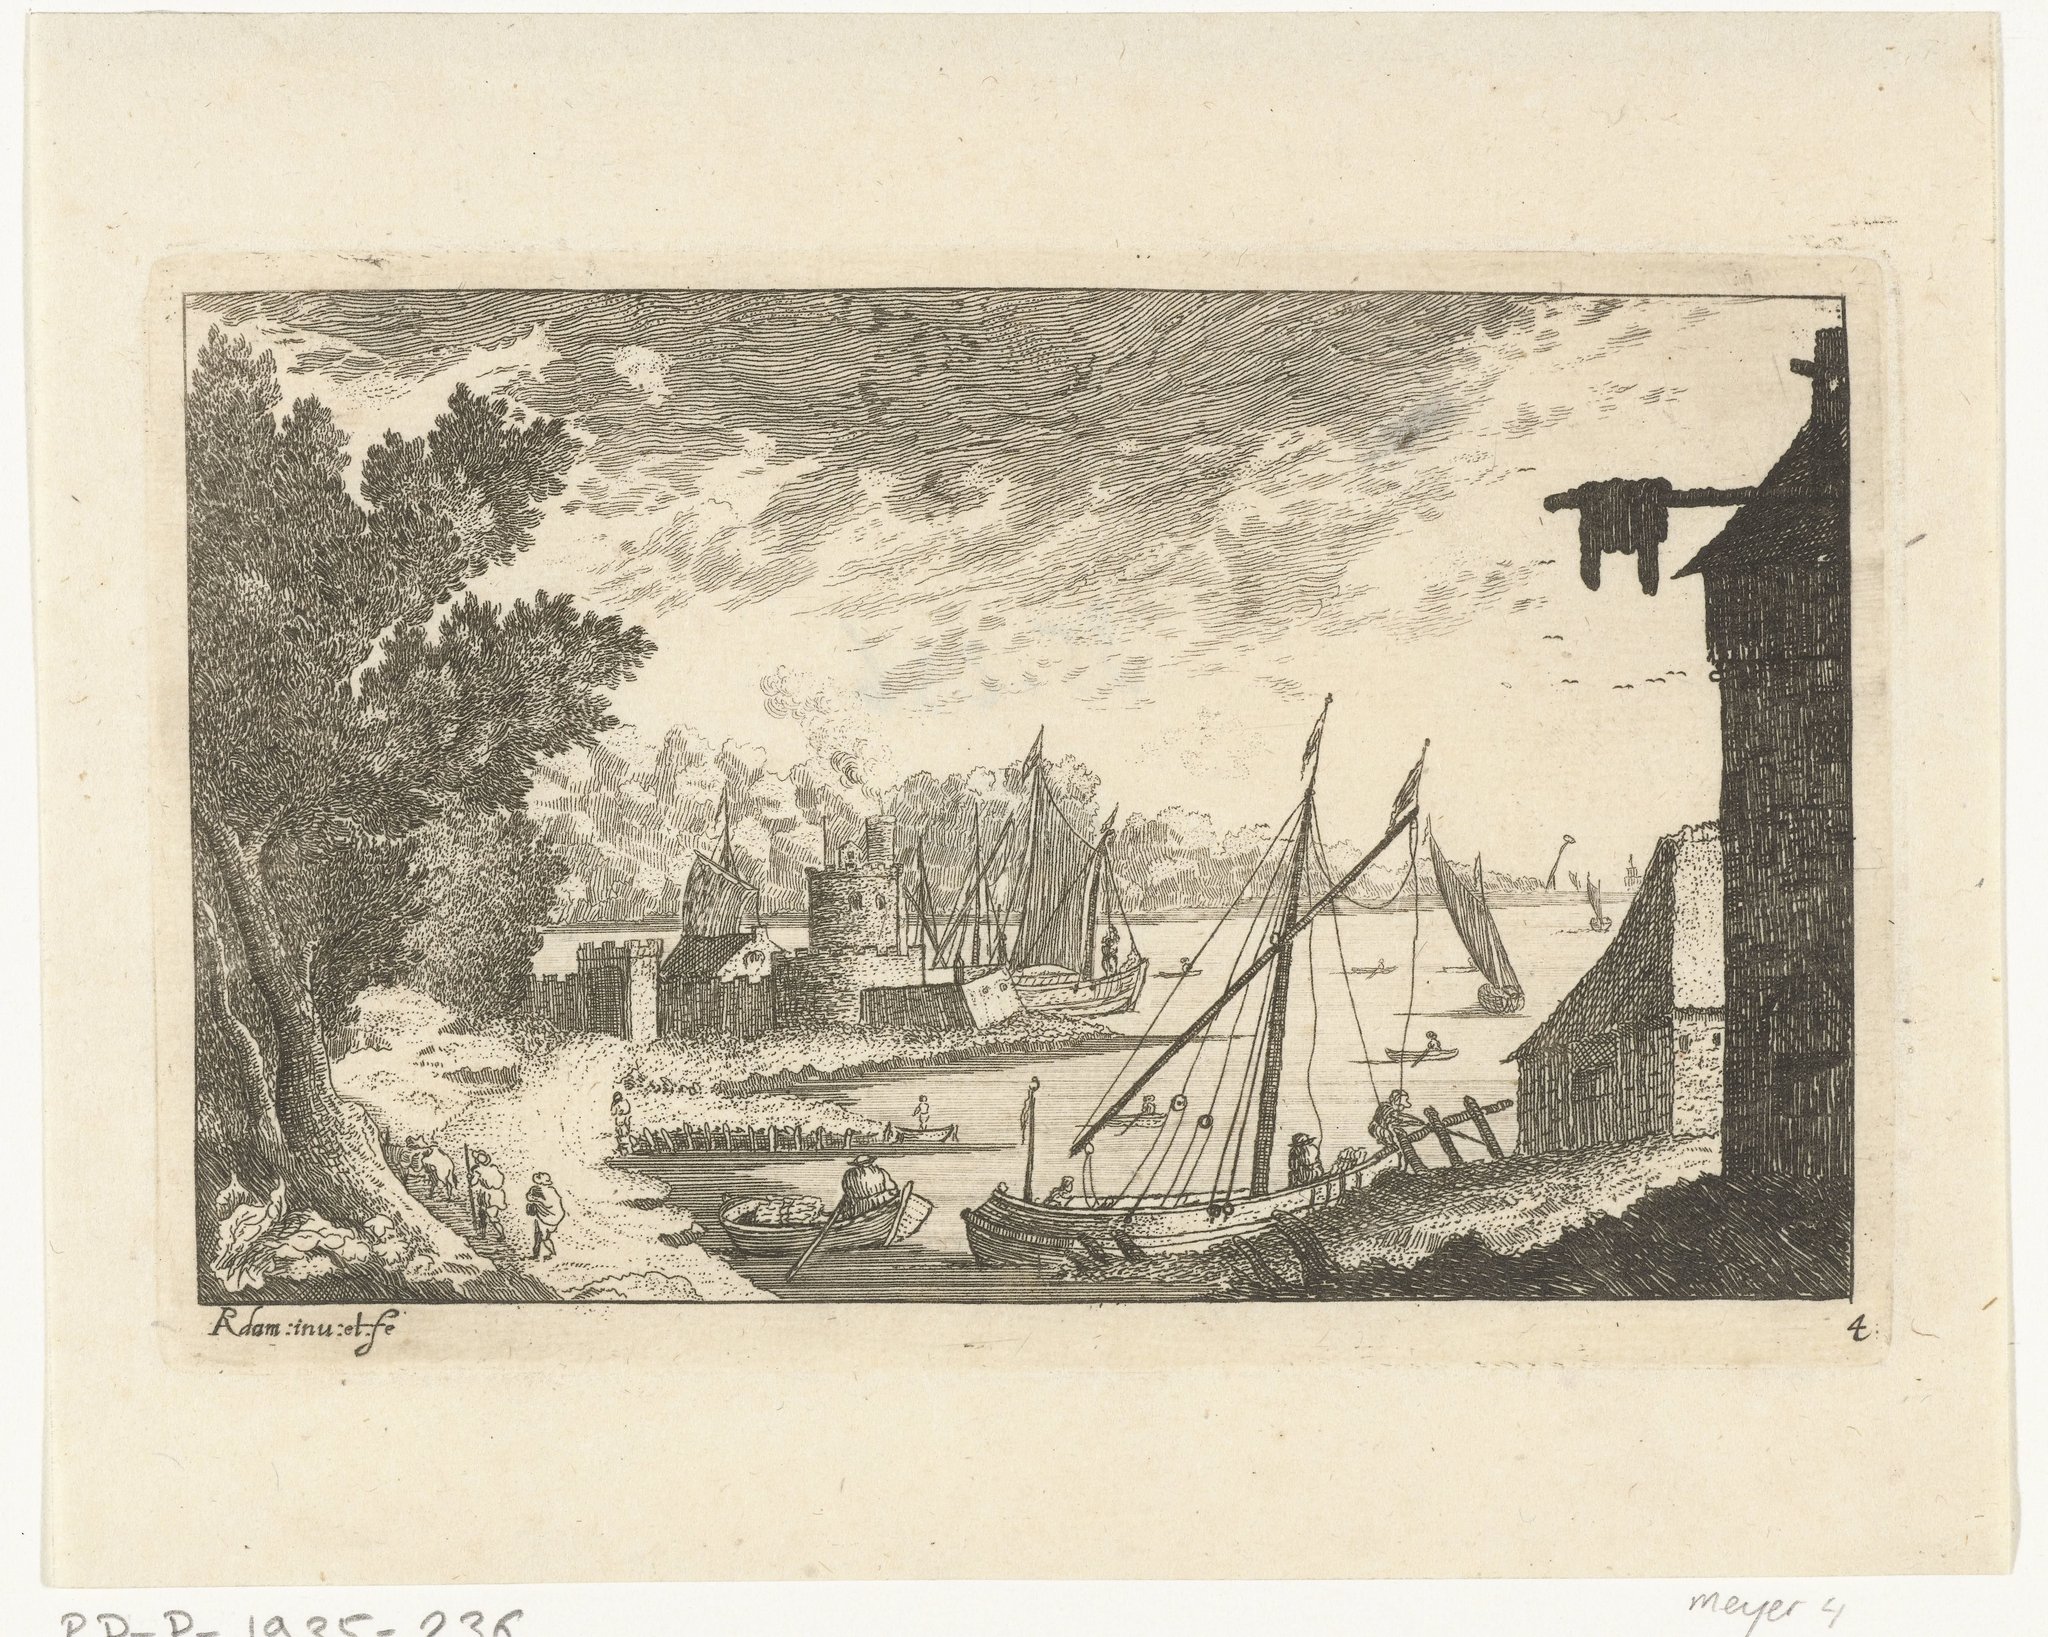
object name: print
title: Vissershaven met aanmerend schip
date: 1654-1693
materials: paper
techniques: etching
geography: amsterdam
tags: harbour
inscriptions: collector's mark: Lugt 2760, collector's mark: Lugt 2228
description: Vissershaven met boten, op de voorgrond een roeiboot en een aanmerend schip met gestreken zeilen. Links drie wandelaars. Op de achtergrond een toren bij de haveningang.